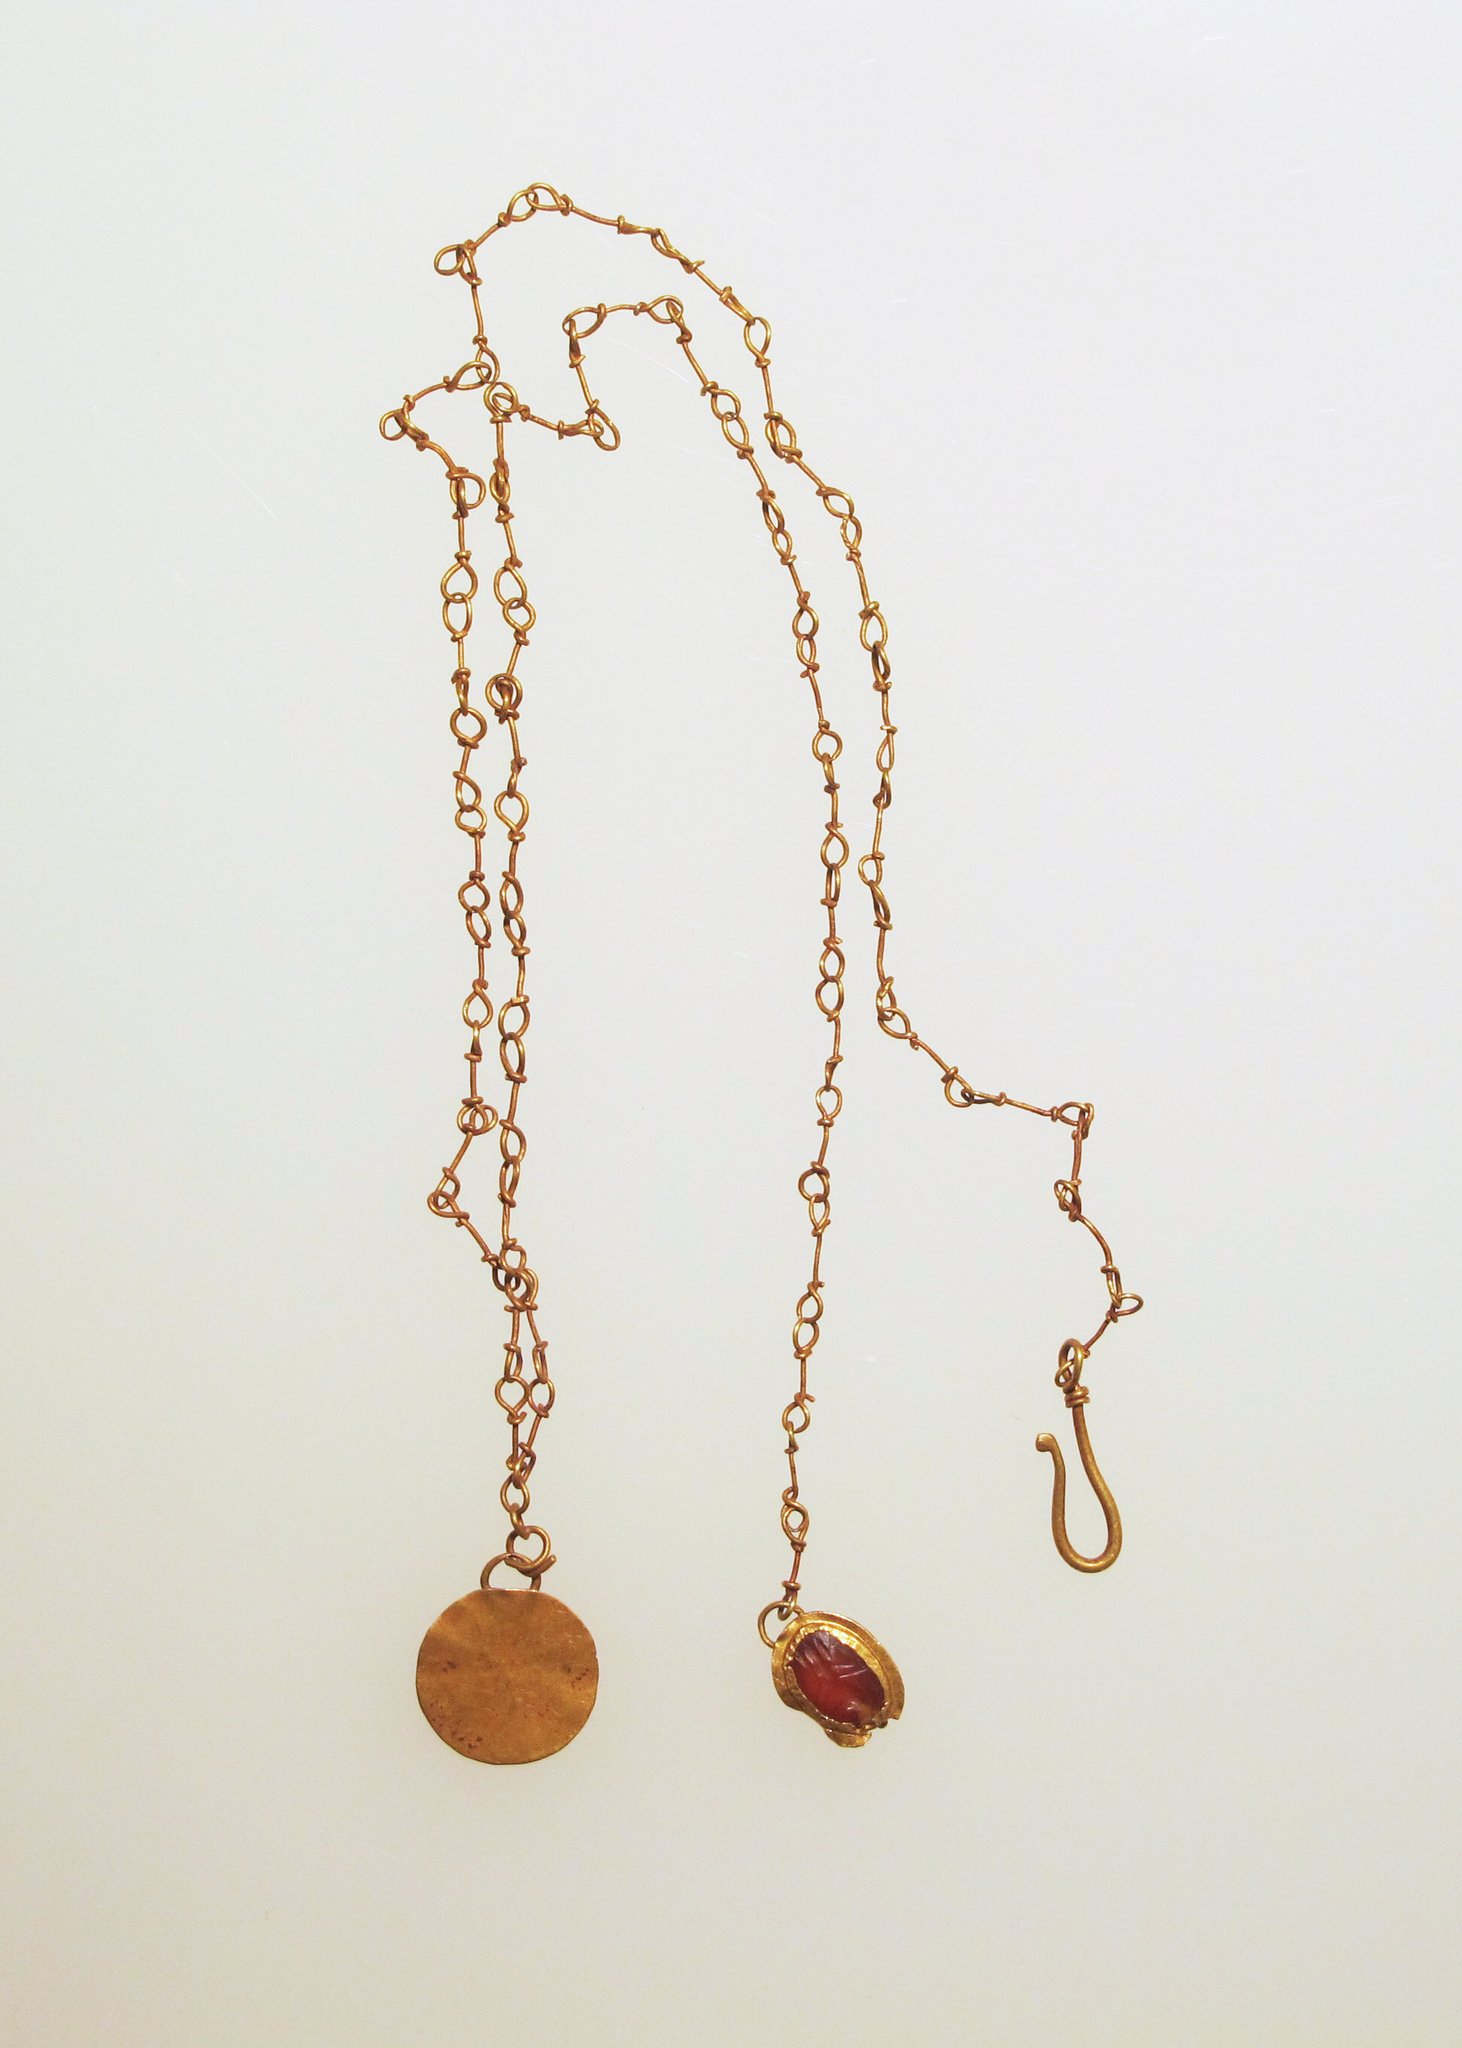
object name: necklace with disc and sard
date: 7000 BCE-330 CE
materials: gold